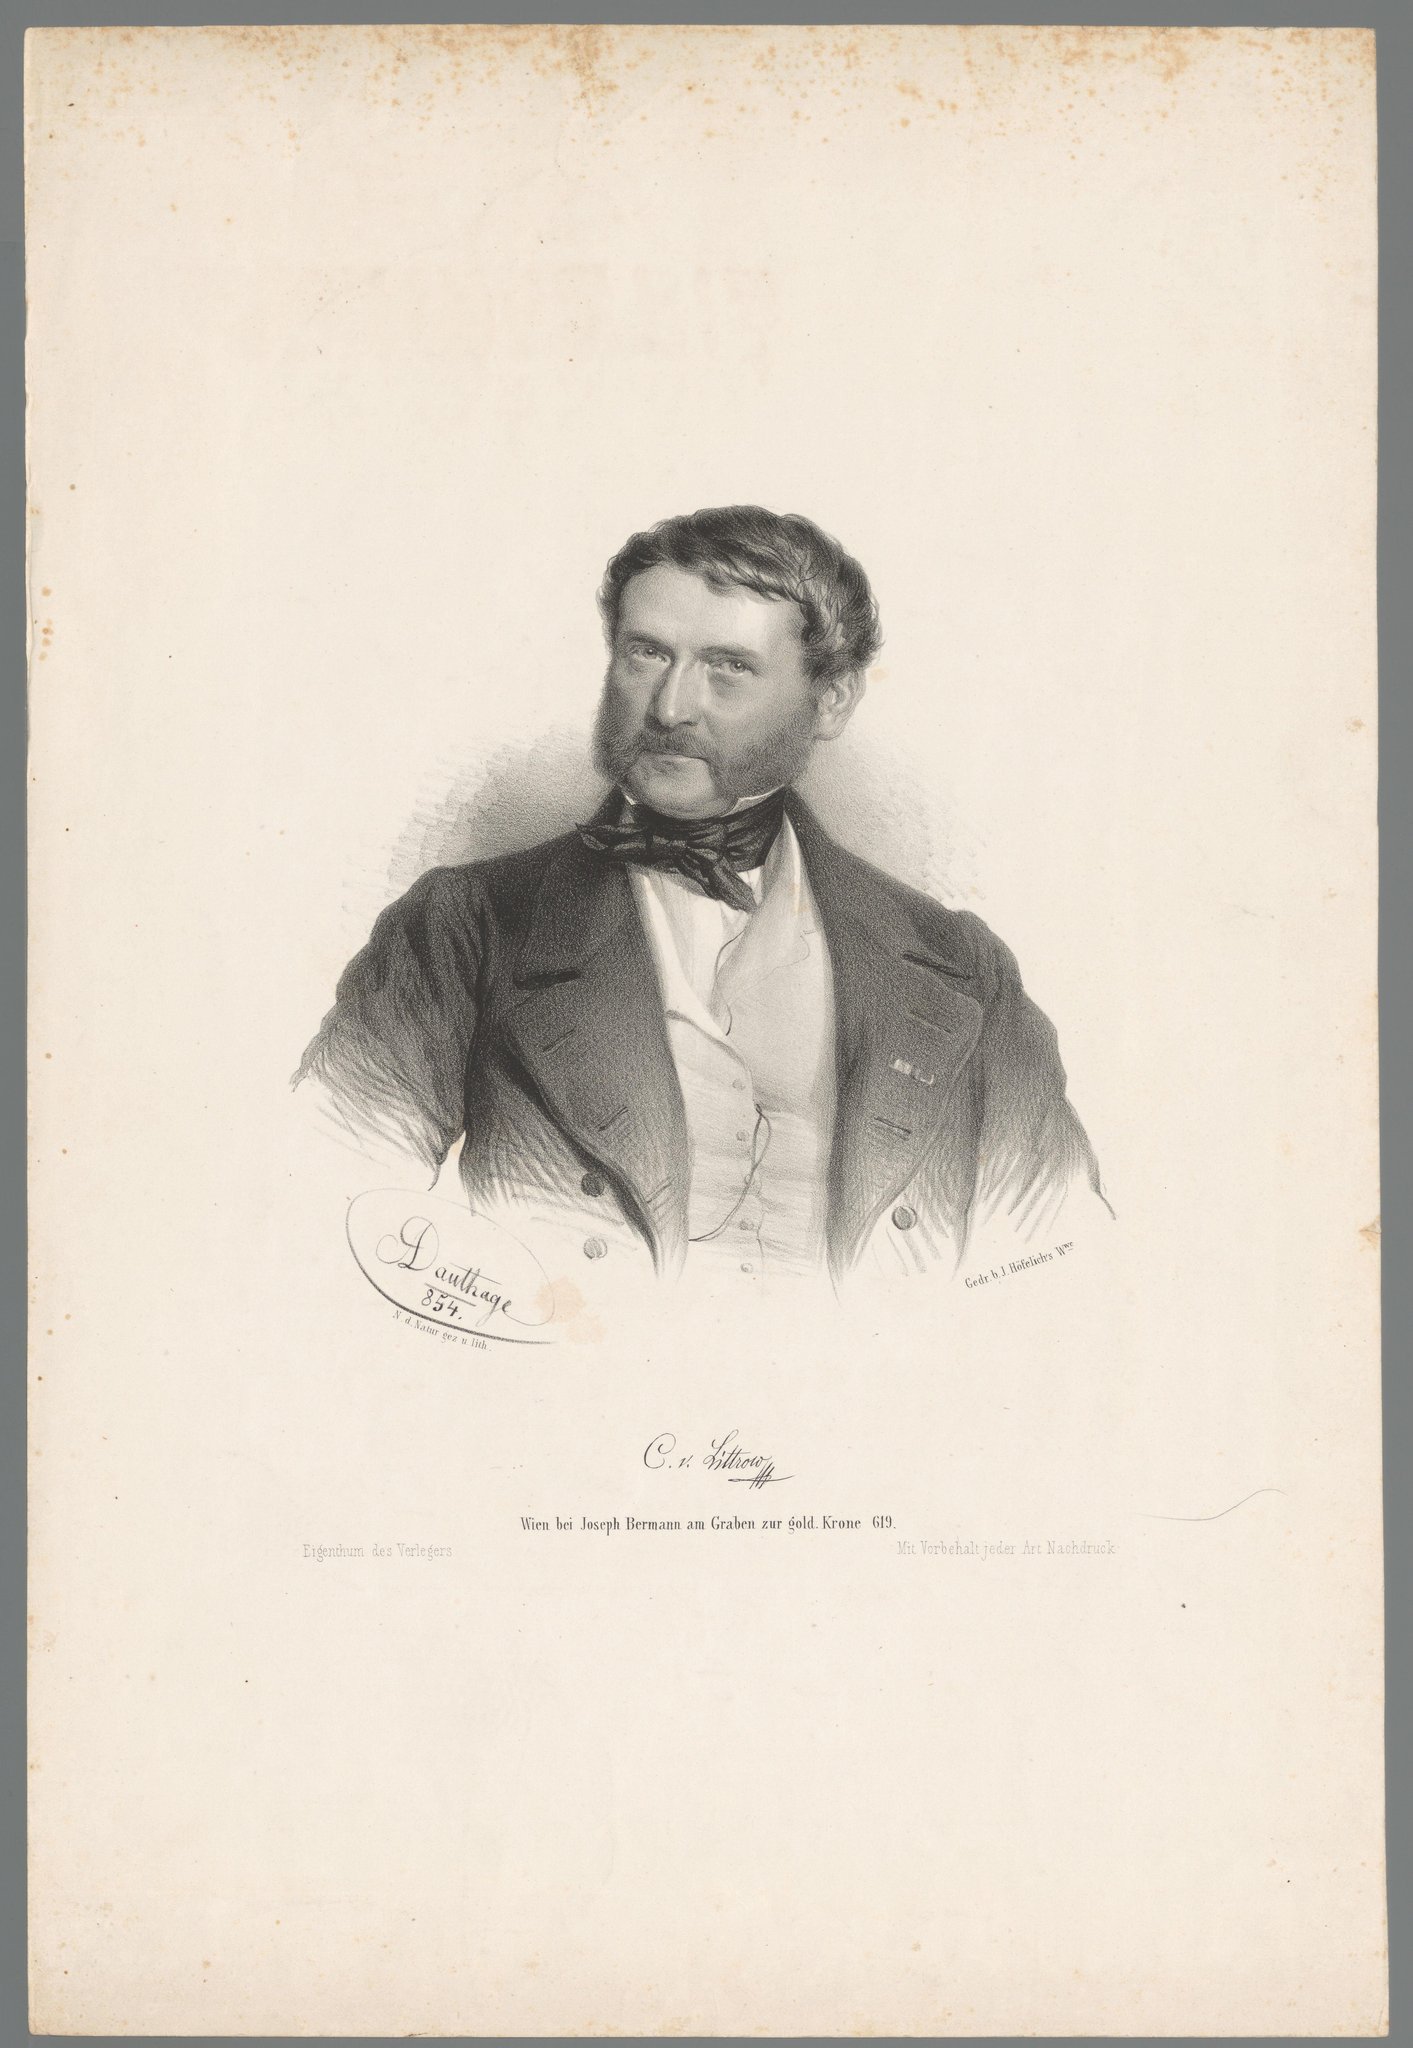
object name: print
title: Portret van Karl Ludwig von Littrow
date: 1854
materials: paper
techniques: lithograph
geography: vienna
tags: venice, astronomy (and cosmography) (+ portrait of scholar, scientist), historical persons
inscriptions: collector's mark: Lugt 2228